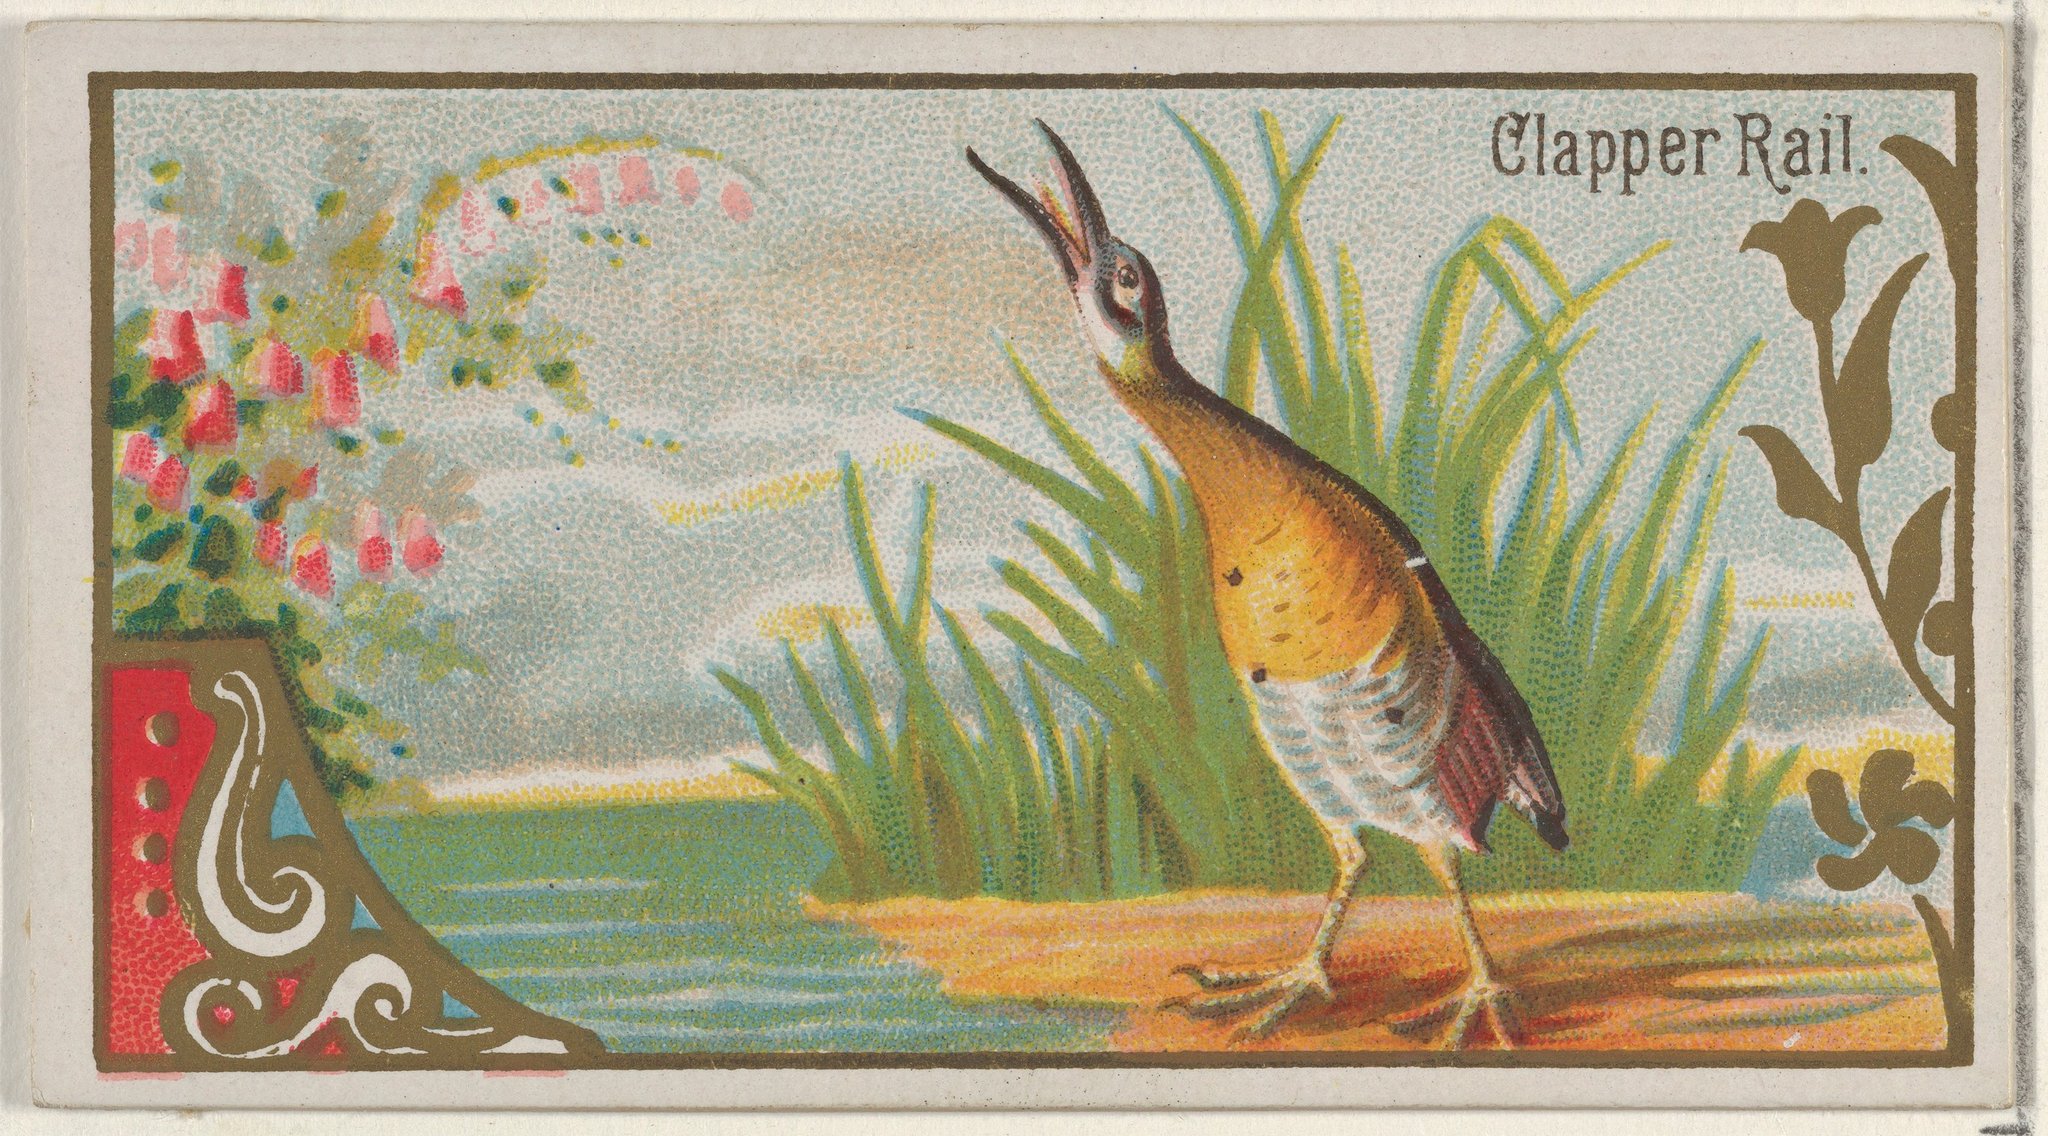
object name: print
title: Clapper Rail, from the Game Birds series (N13) for Allen & Ginter Cigarettes Brands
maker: allen & ginter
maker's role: publisher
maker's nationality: american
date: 1889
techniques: color lithograph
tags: birds